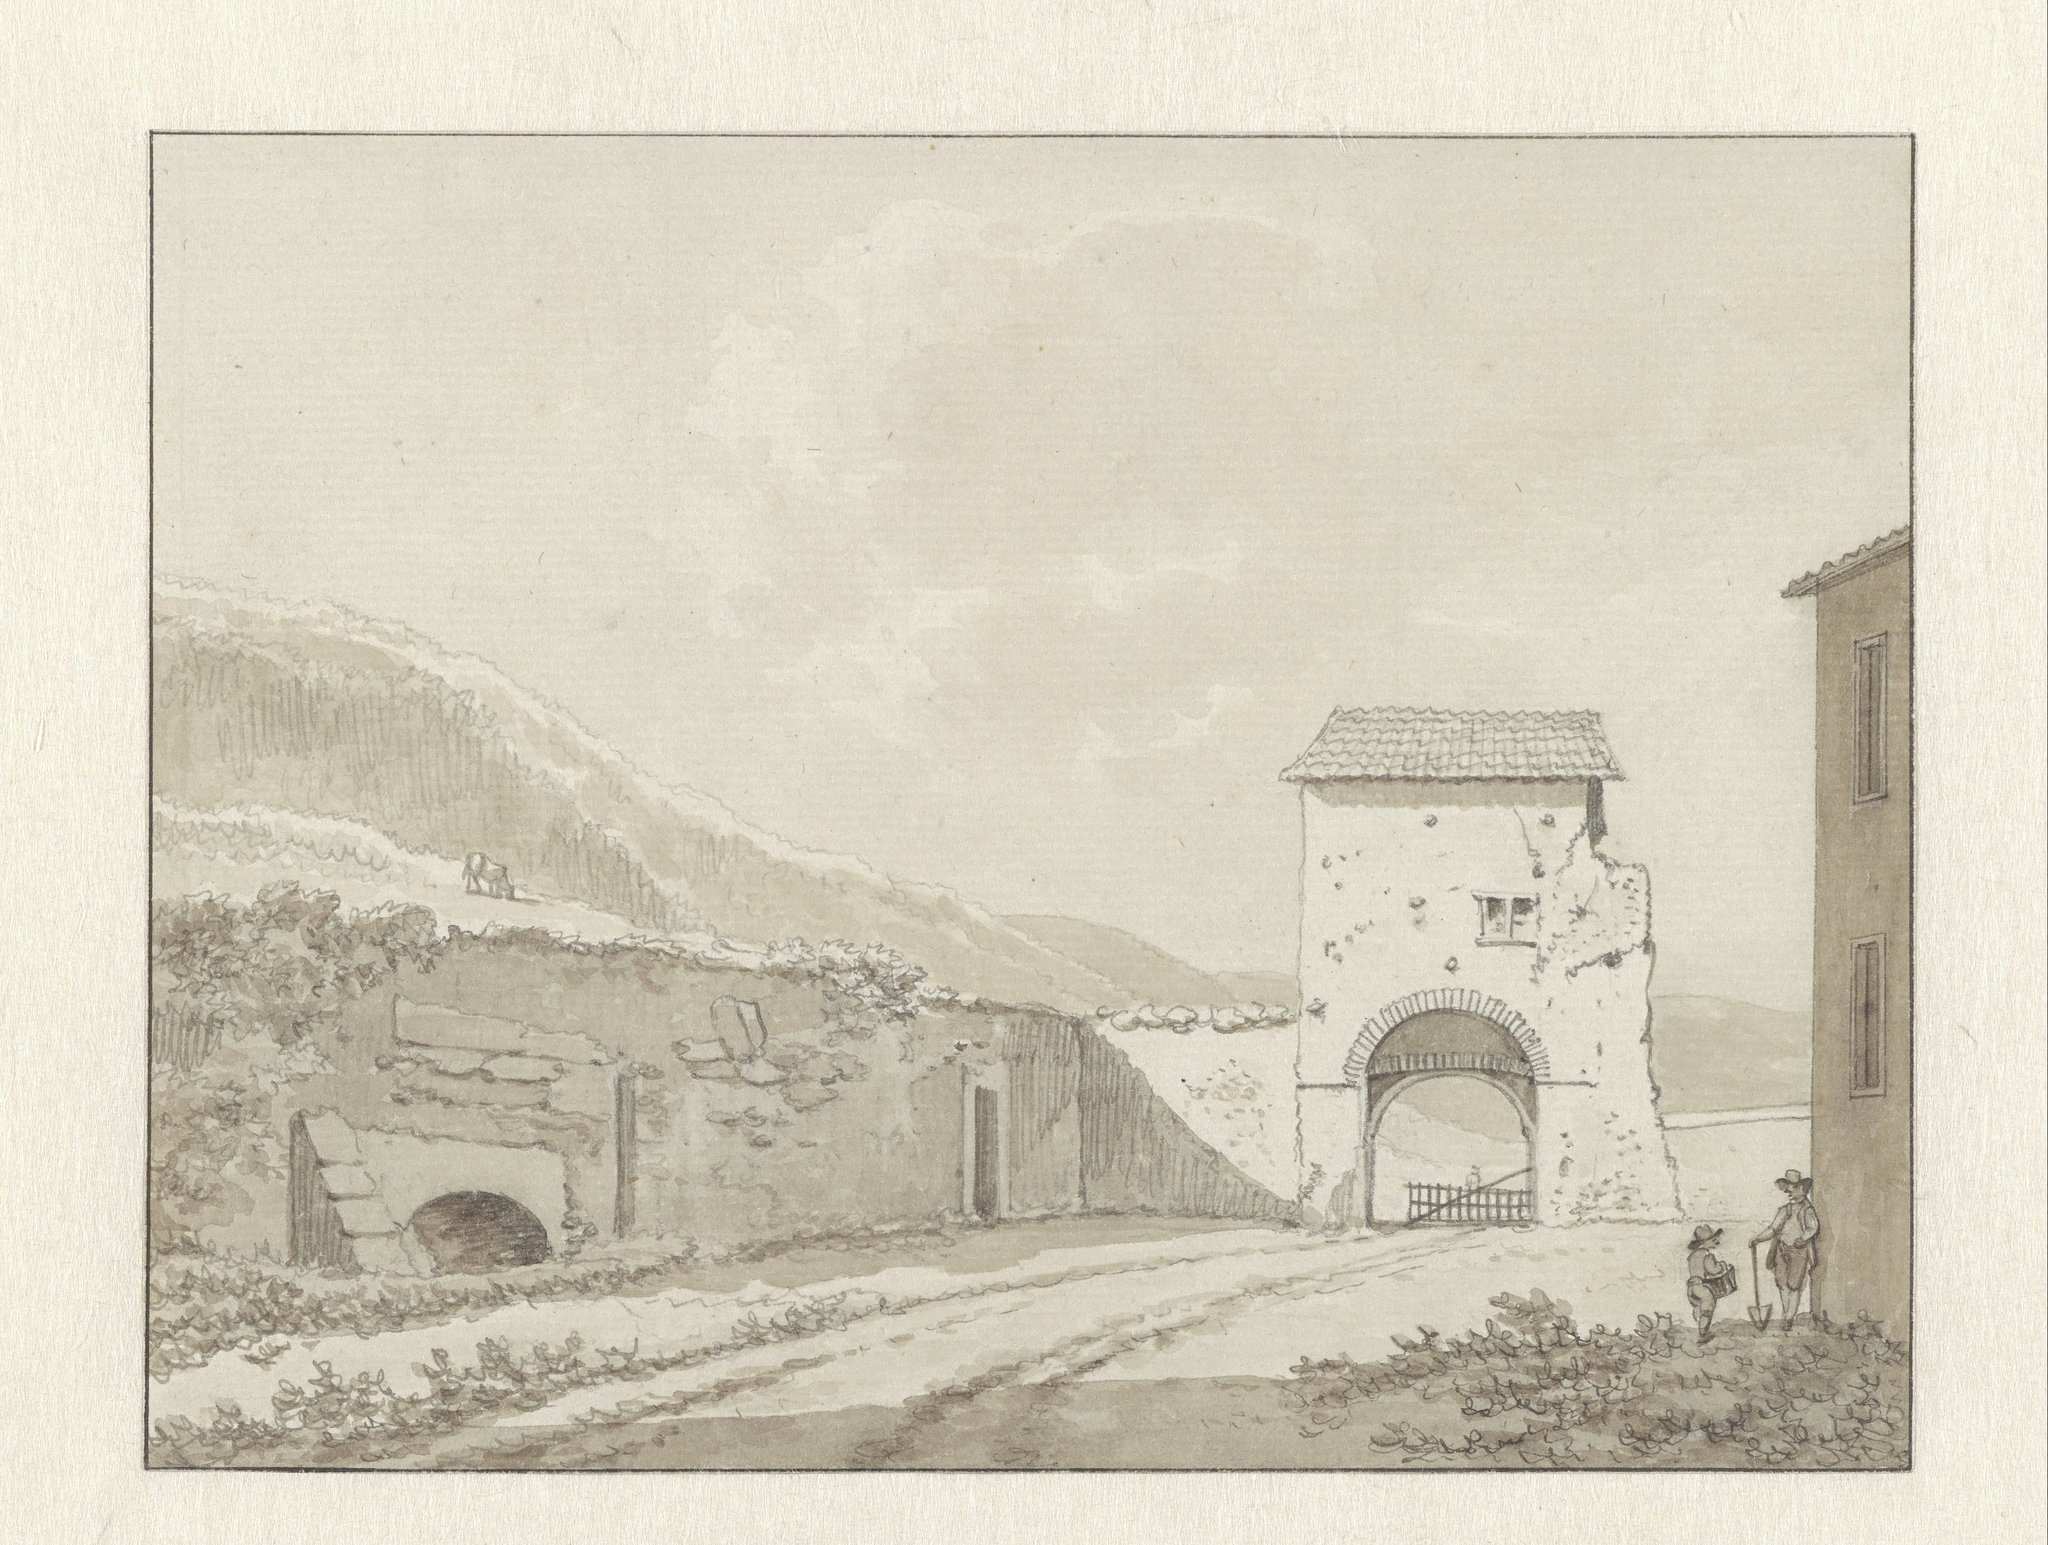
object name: drawing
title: Gezicht in Rome, bij kerk van S. Paolo alle Tre Fontane, buiten de Porta San Paolo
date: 1761-1817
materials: graphite, ink, paper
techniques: brush, pen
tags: city-gate, rome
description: Tekening uit een groep tekeningen van landschappen en stadsgezichten in Italië (Rome, Tivoli, Civita Castellana en Pozzuoli).